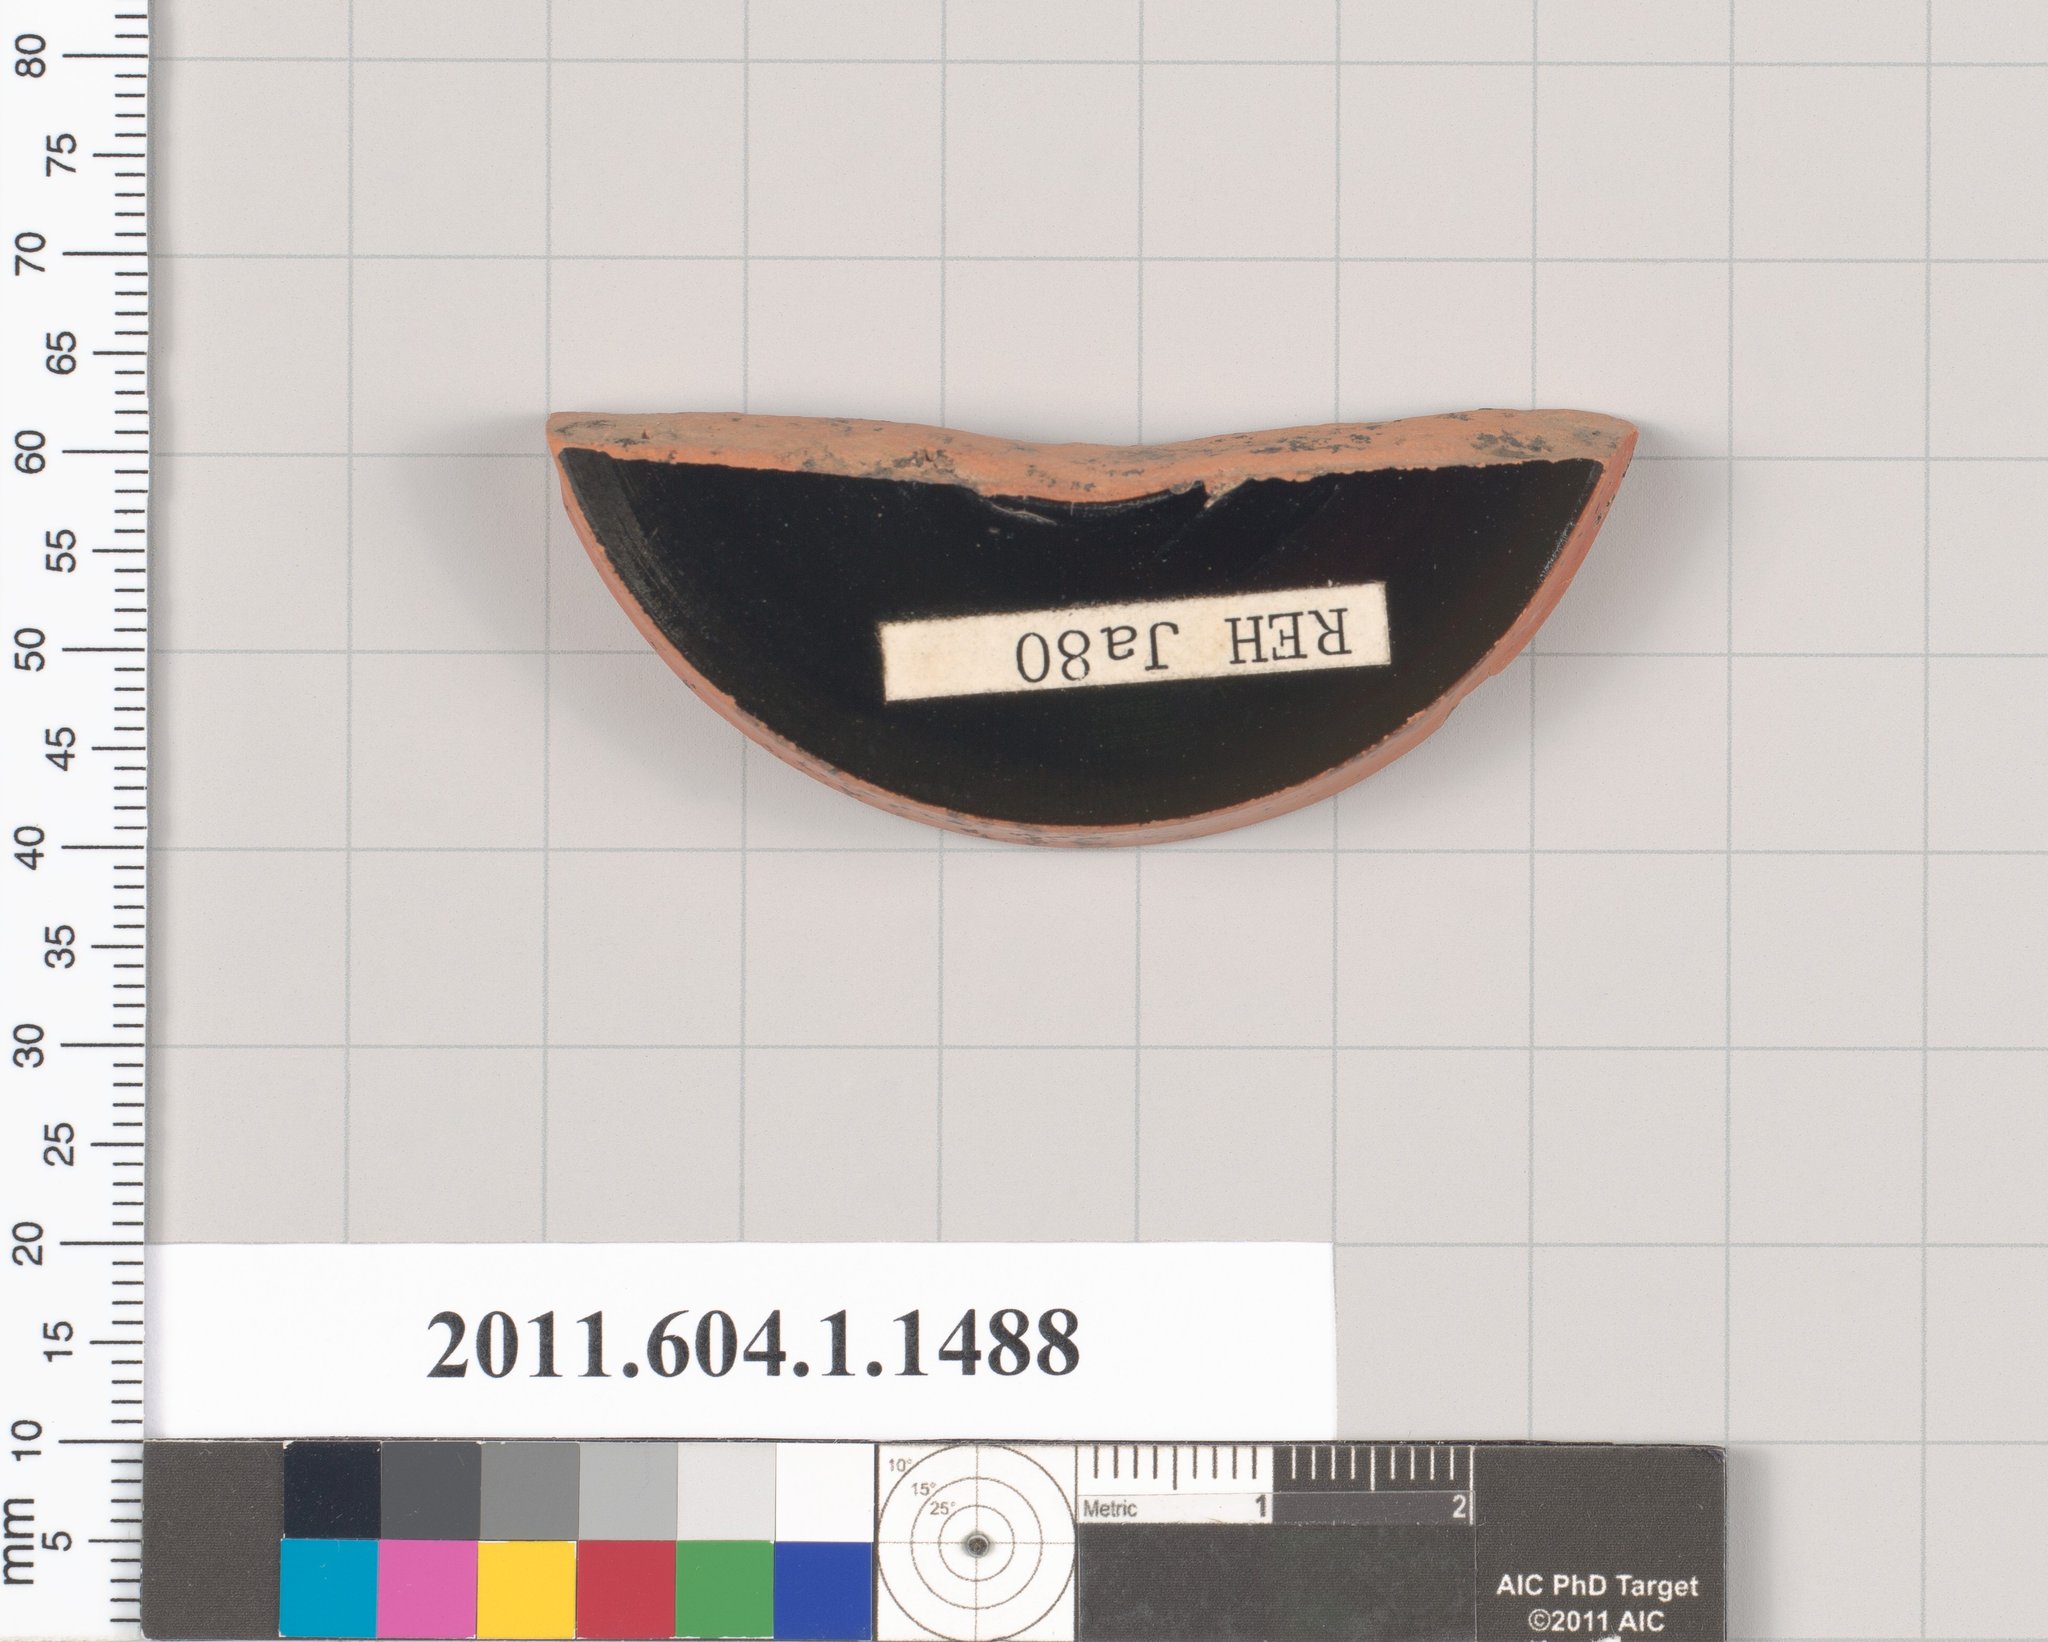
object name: kylix fragment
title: Terracotta fragment of a kylix? (drinking cup)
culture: greek, attic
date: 500-401 BCE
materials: terracotta